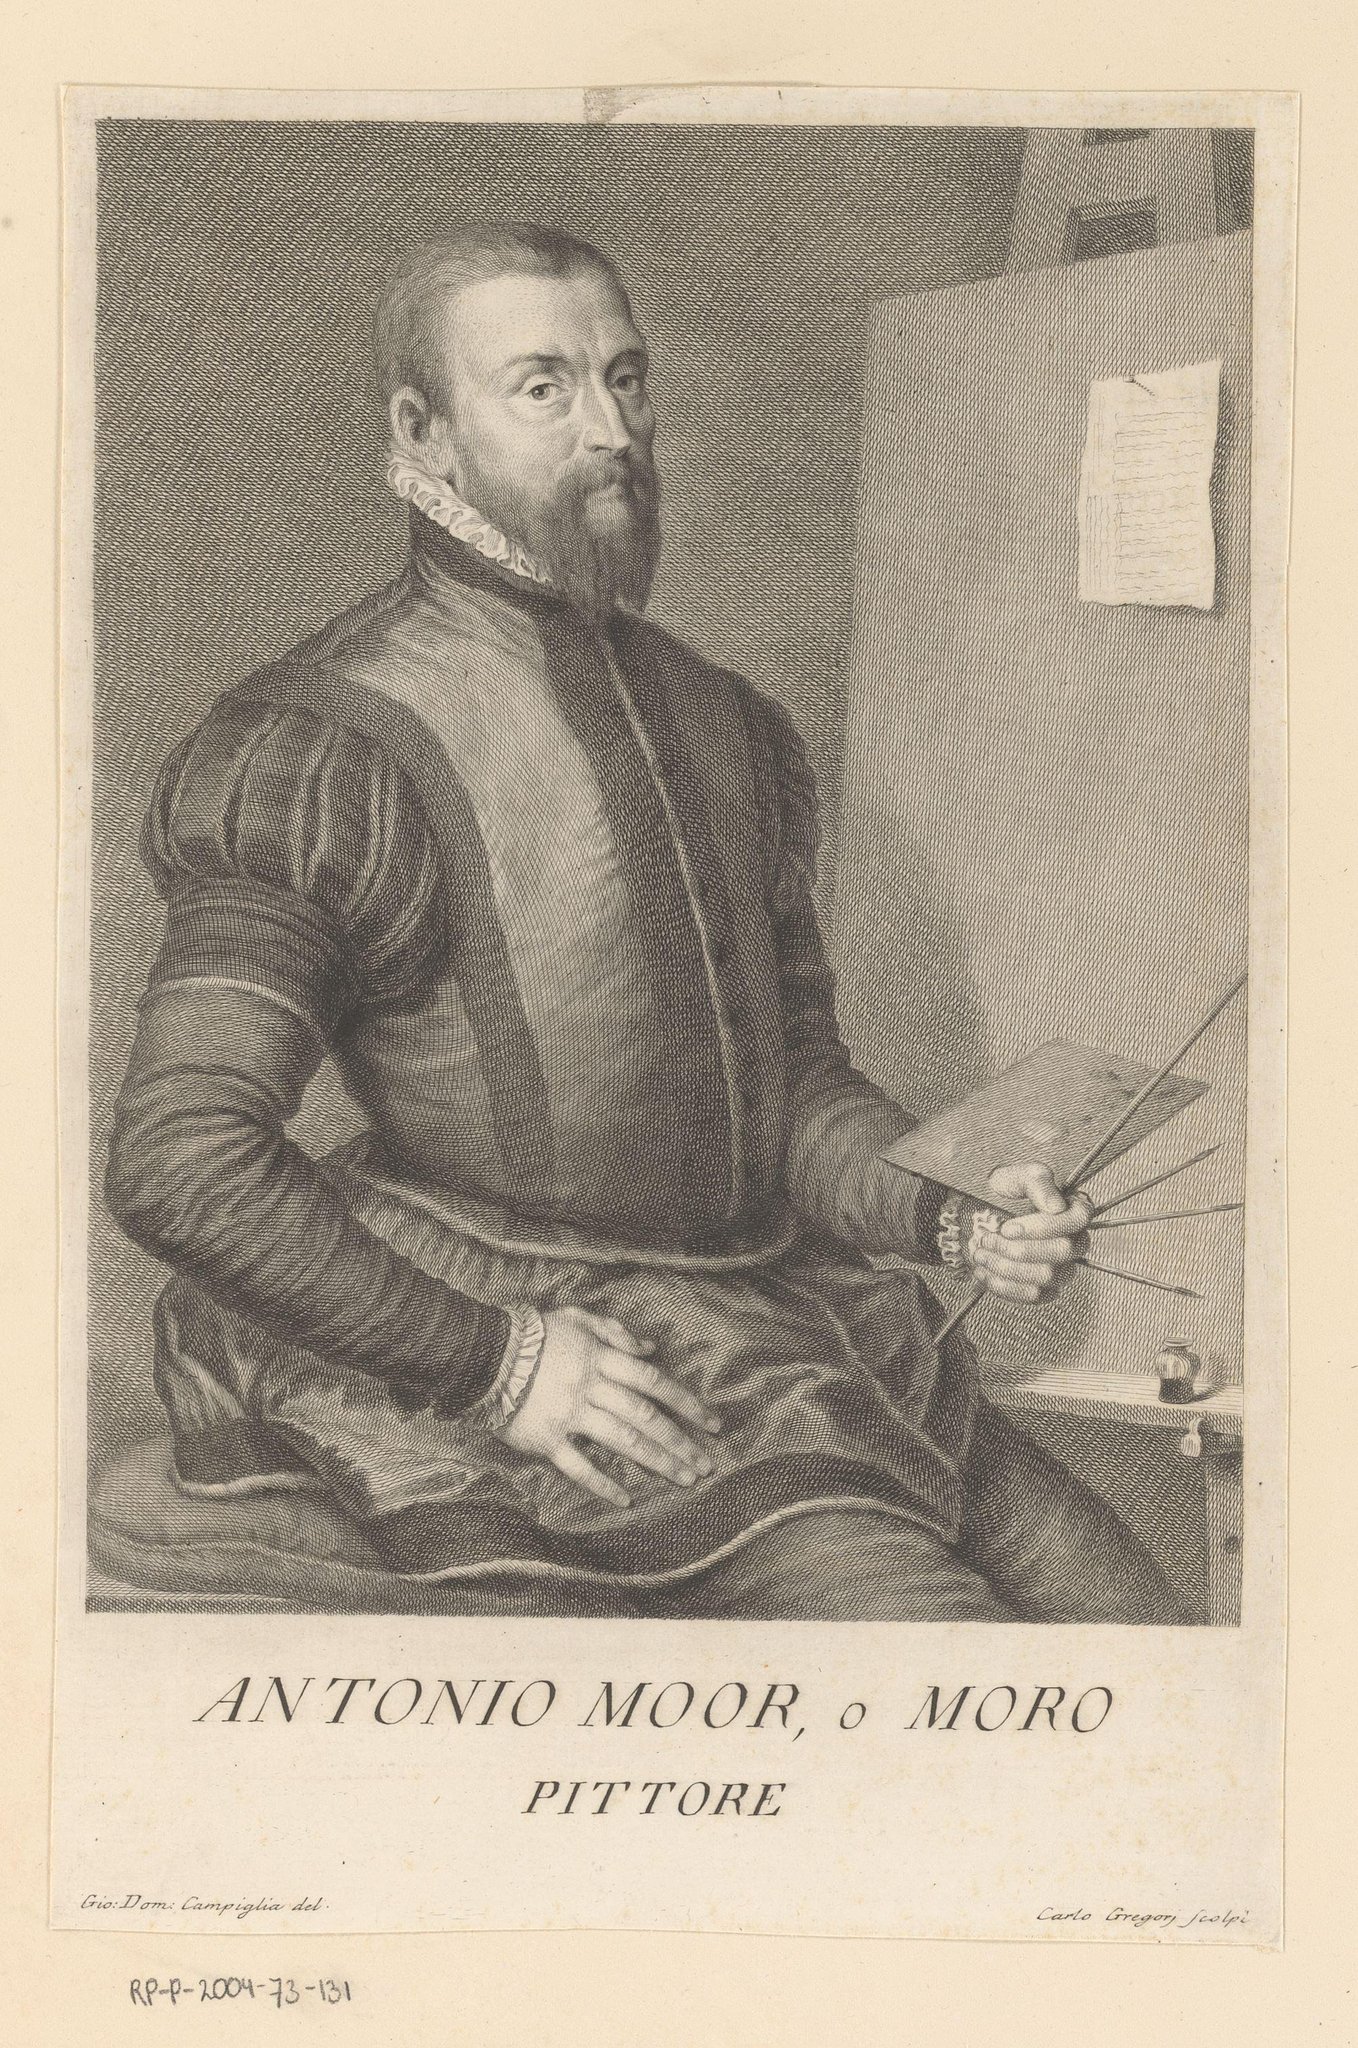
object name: album leaf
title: Museum Florentinum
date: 1752-1766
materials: paper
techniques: engraving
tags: utrecht, painter, draughtsman, anthonis mor, historical persons, portrait, self-portrait of painter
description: Prent is onderdeel van een serie getiteld 'Museum Florentinum', bestaande uit vier subsecties: 'Gemmae antiquae ex Thesauro Mediceo et privatorum dactyliothecis florentiae...' (1730-1731), 'Statuae antiquae dorum et virorum illustrium' (1734), 'Antiqua numismata aurea et argentea' (1740-1741) en 'Serie di ritratti degli eccellenti pittori' (1752-1766). Het vierde deel bestaat uit 320 kunstenaarsportretten en is uitgegeven in boekvorm (vier delen). Prent uit: Prent uit: Moücke, Francesco. Serie di ritratti degli eccellenti pittori : dipinti di propria mano che esistono nell'Imperial galleria di Firenze. 4 dln. Florence: Francesco Moücke, 1754, dl. 1, p. 126. De samensteller heeft deze prent in het album geplakt als illustratie bij: Pilkington, Matthew en Johann Heinrich Füssli. A dictionary of painters, from the revival of the art to the present period. 4 dln. Londen: John Crowder, 1805, dl. 2, p. 301.